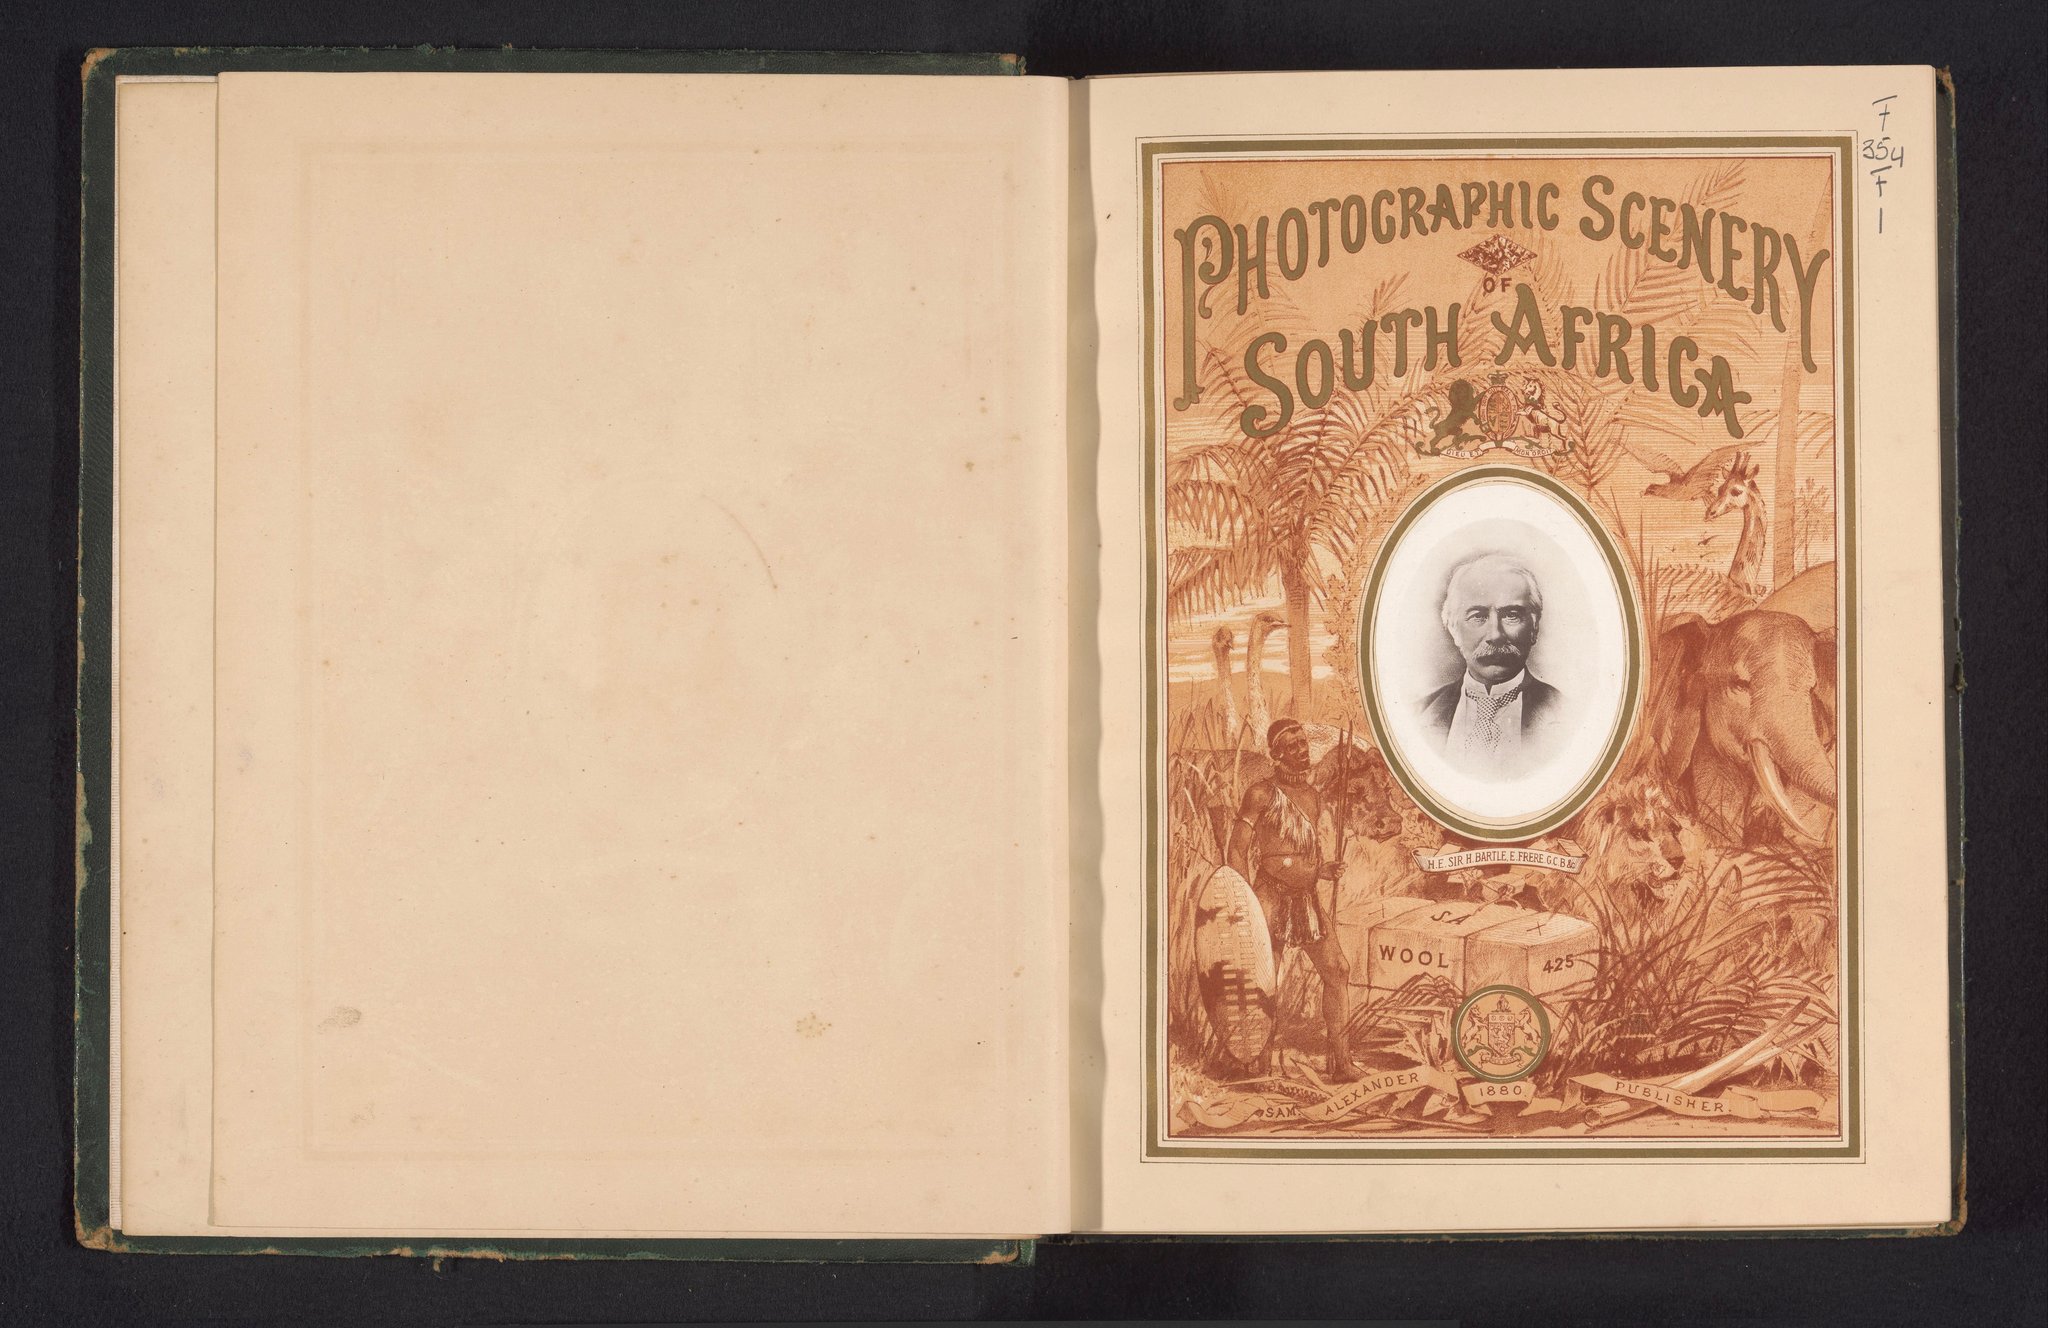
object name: page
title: H.E. Sir H. Bartle, E. Frere, G.C.B.&c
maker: Anonymous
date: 1875-1880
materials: paper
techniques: photograph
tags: colonial governor